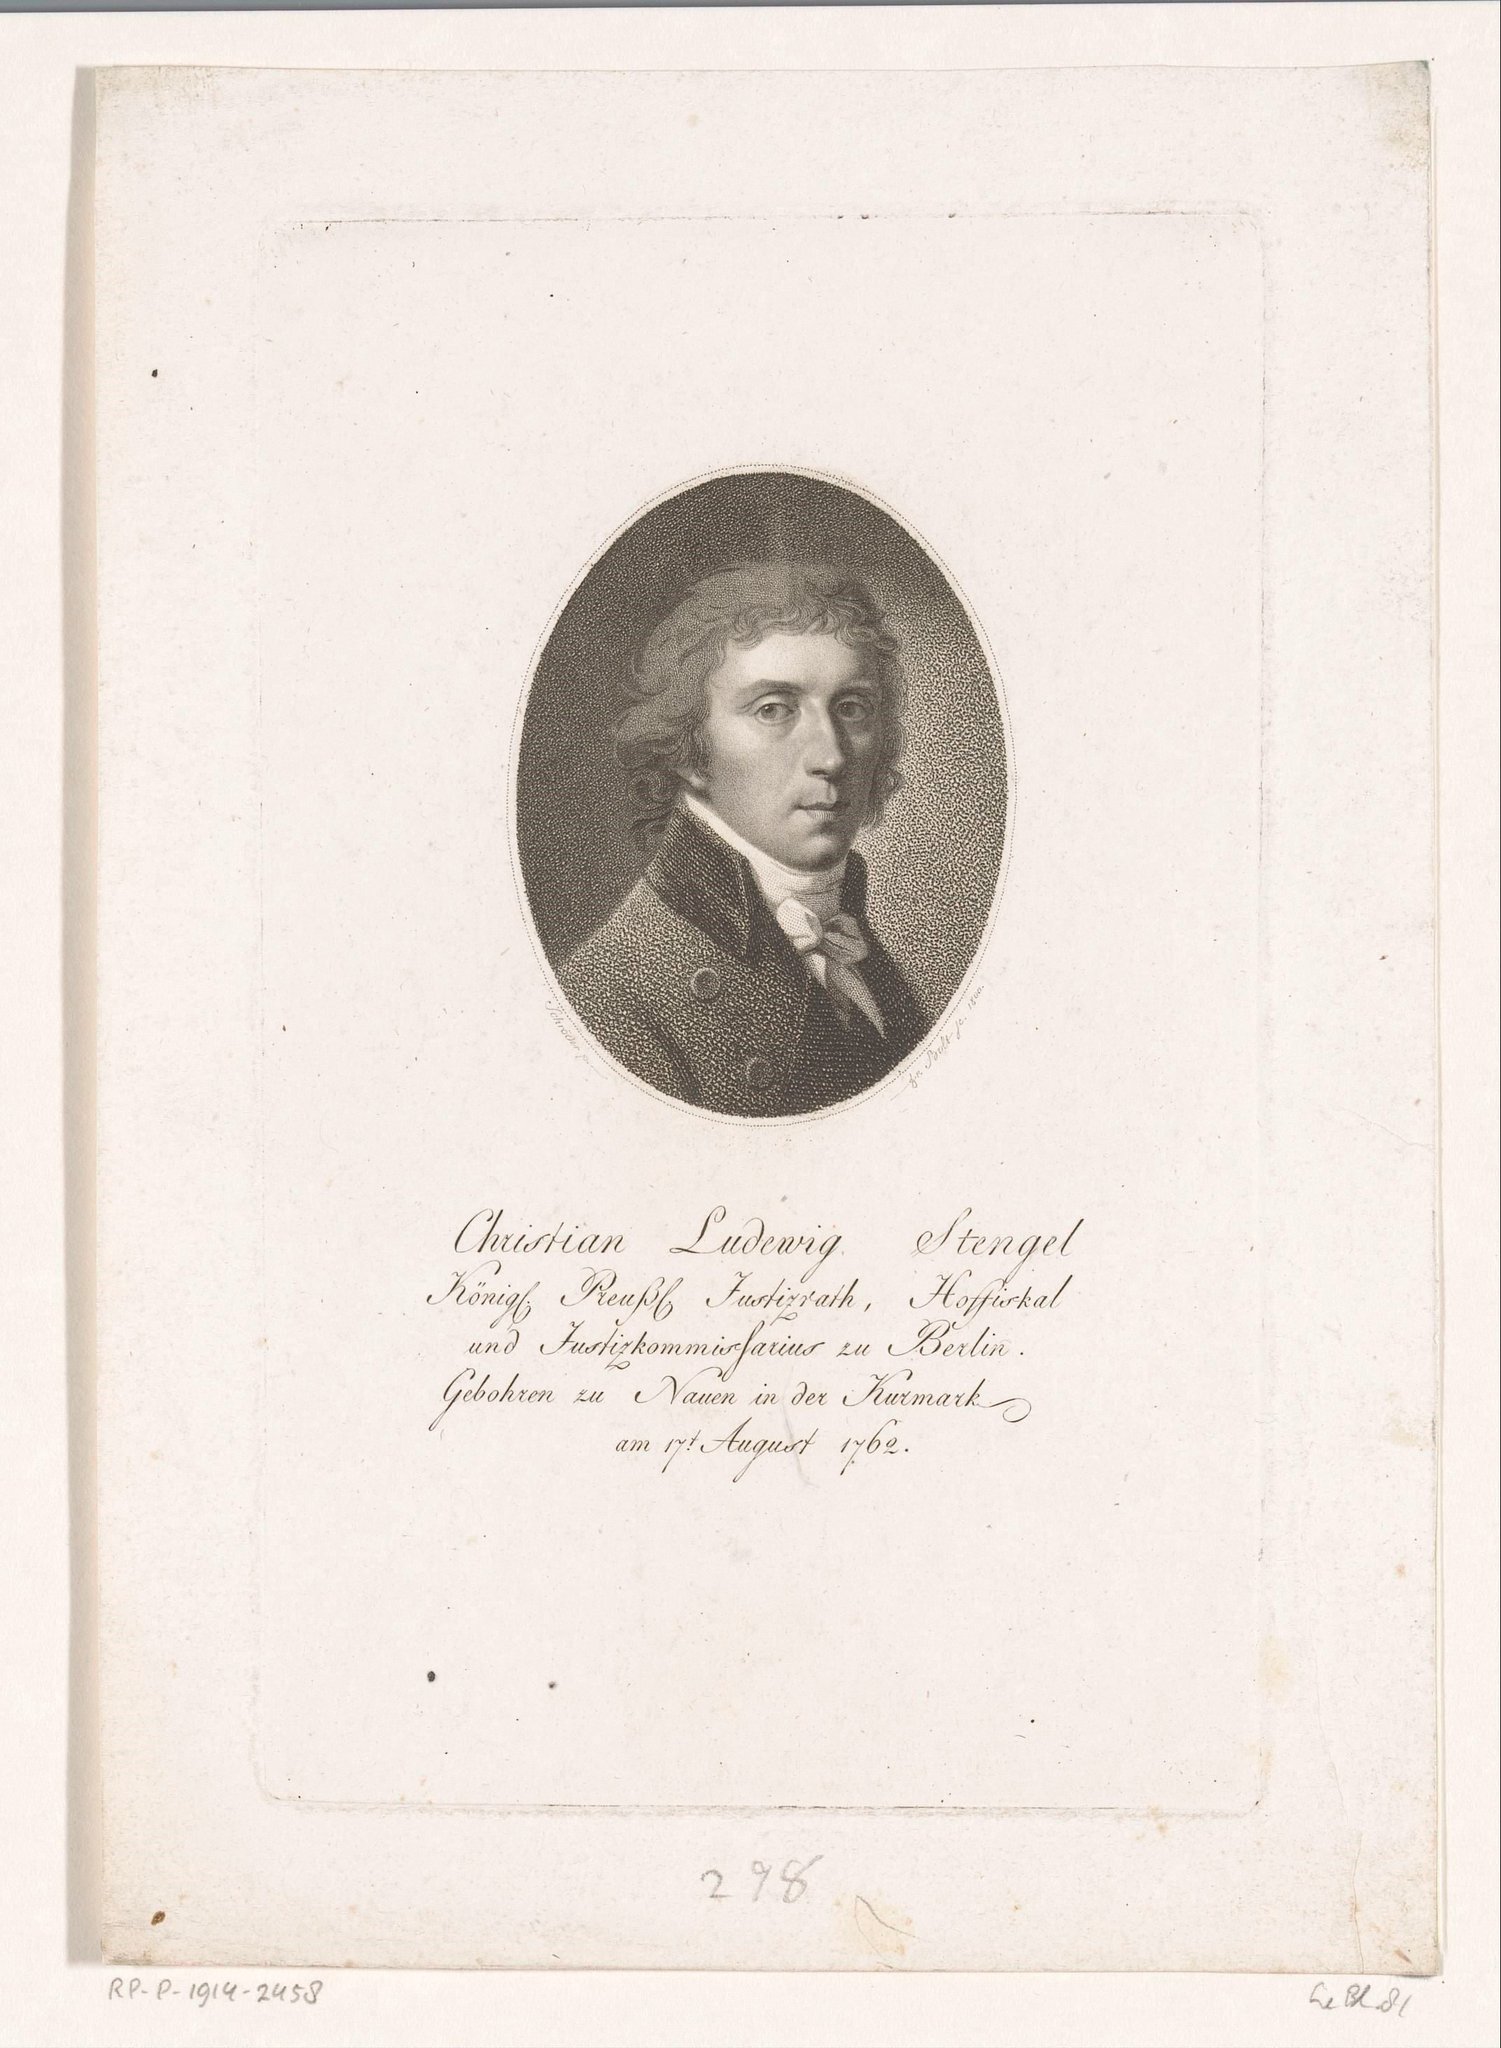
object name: print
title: Portret van Christian Ludwig Stengel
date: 1800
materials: paper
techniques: stippling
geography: berlin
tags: berlin, historical persons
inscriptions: collector's mark: Lugt 2228